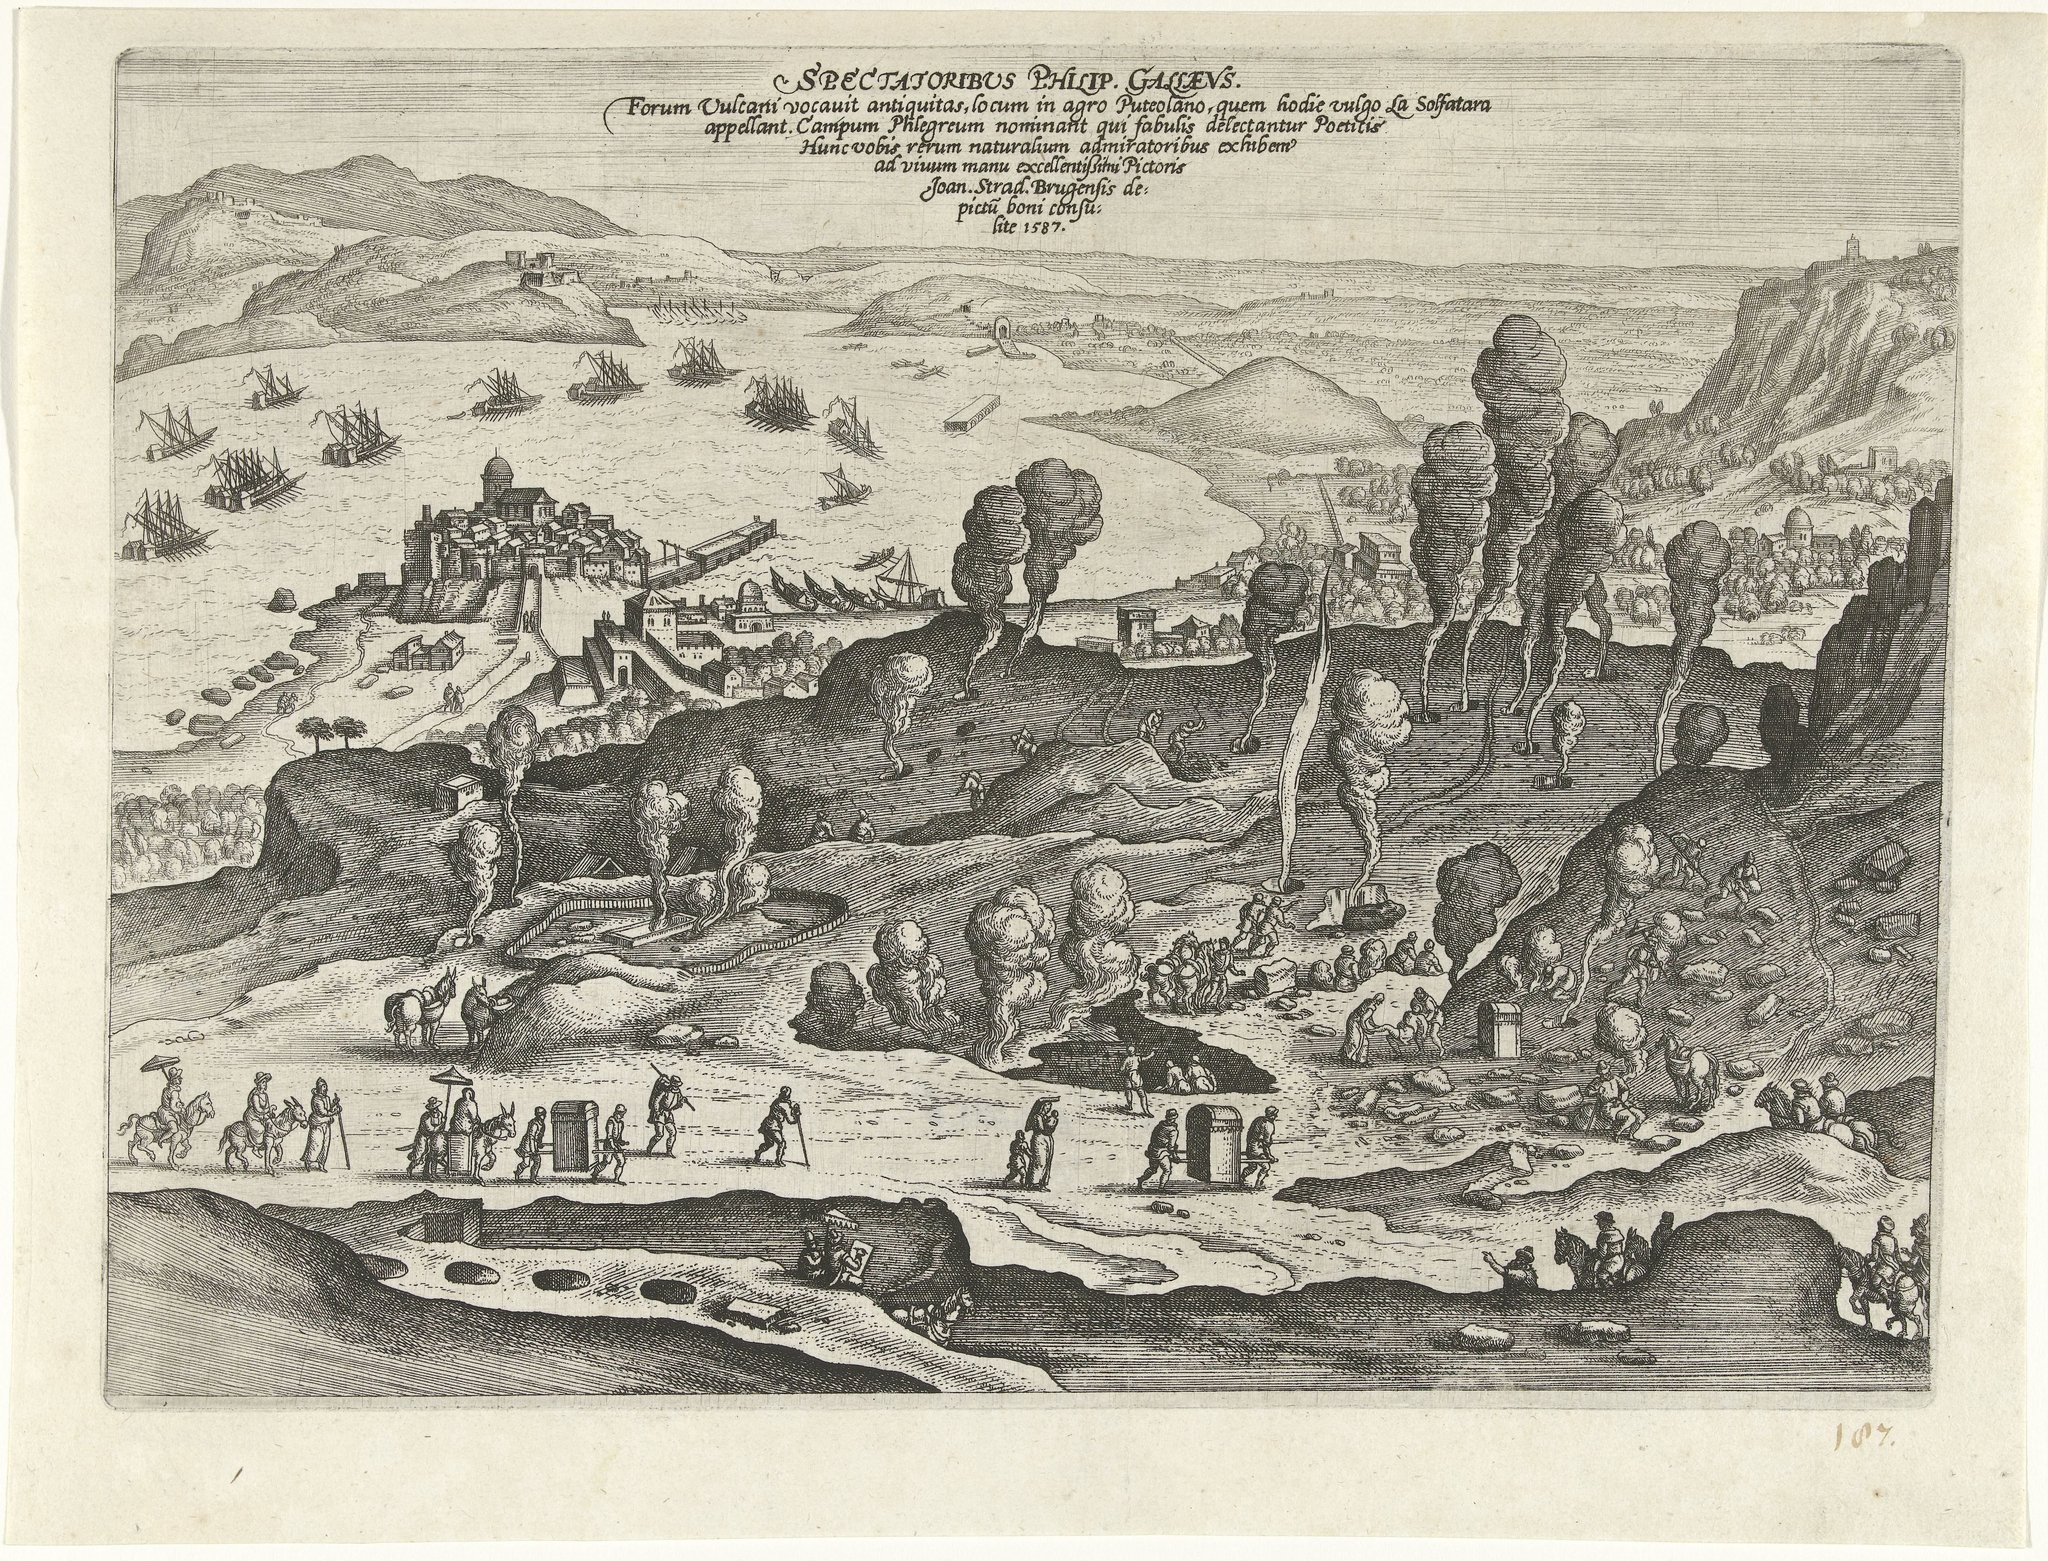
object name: print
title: Gezicht op de zwavelbronnen van Pozzuoli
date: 1587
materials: paper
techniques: etching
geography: florence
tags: pozzuoli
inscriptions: number: ‘187’, collector's mark: Lugt 2228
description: De zwavelbronnen bij de vulkaan van Pozzuoli. Reizigers komen de werken bezichtigen. Kunstenaars schetsen de werkzaamheden. Enkele werkers worden afgevoerd die omwille van de dampen onwel zijn geworden. In de achtergrond de havenplaats Pozzuoli. De prent heeft een Latijns bovenschrift.